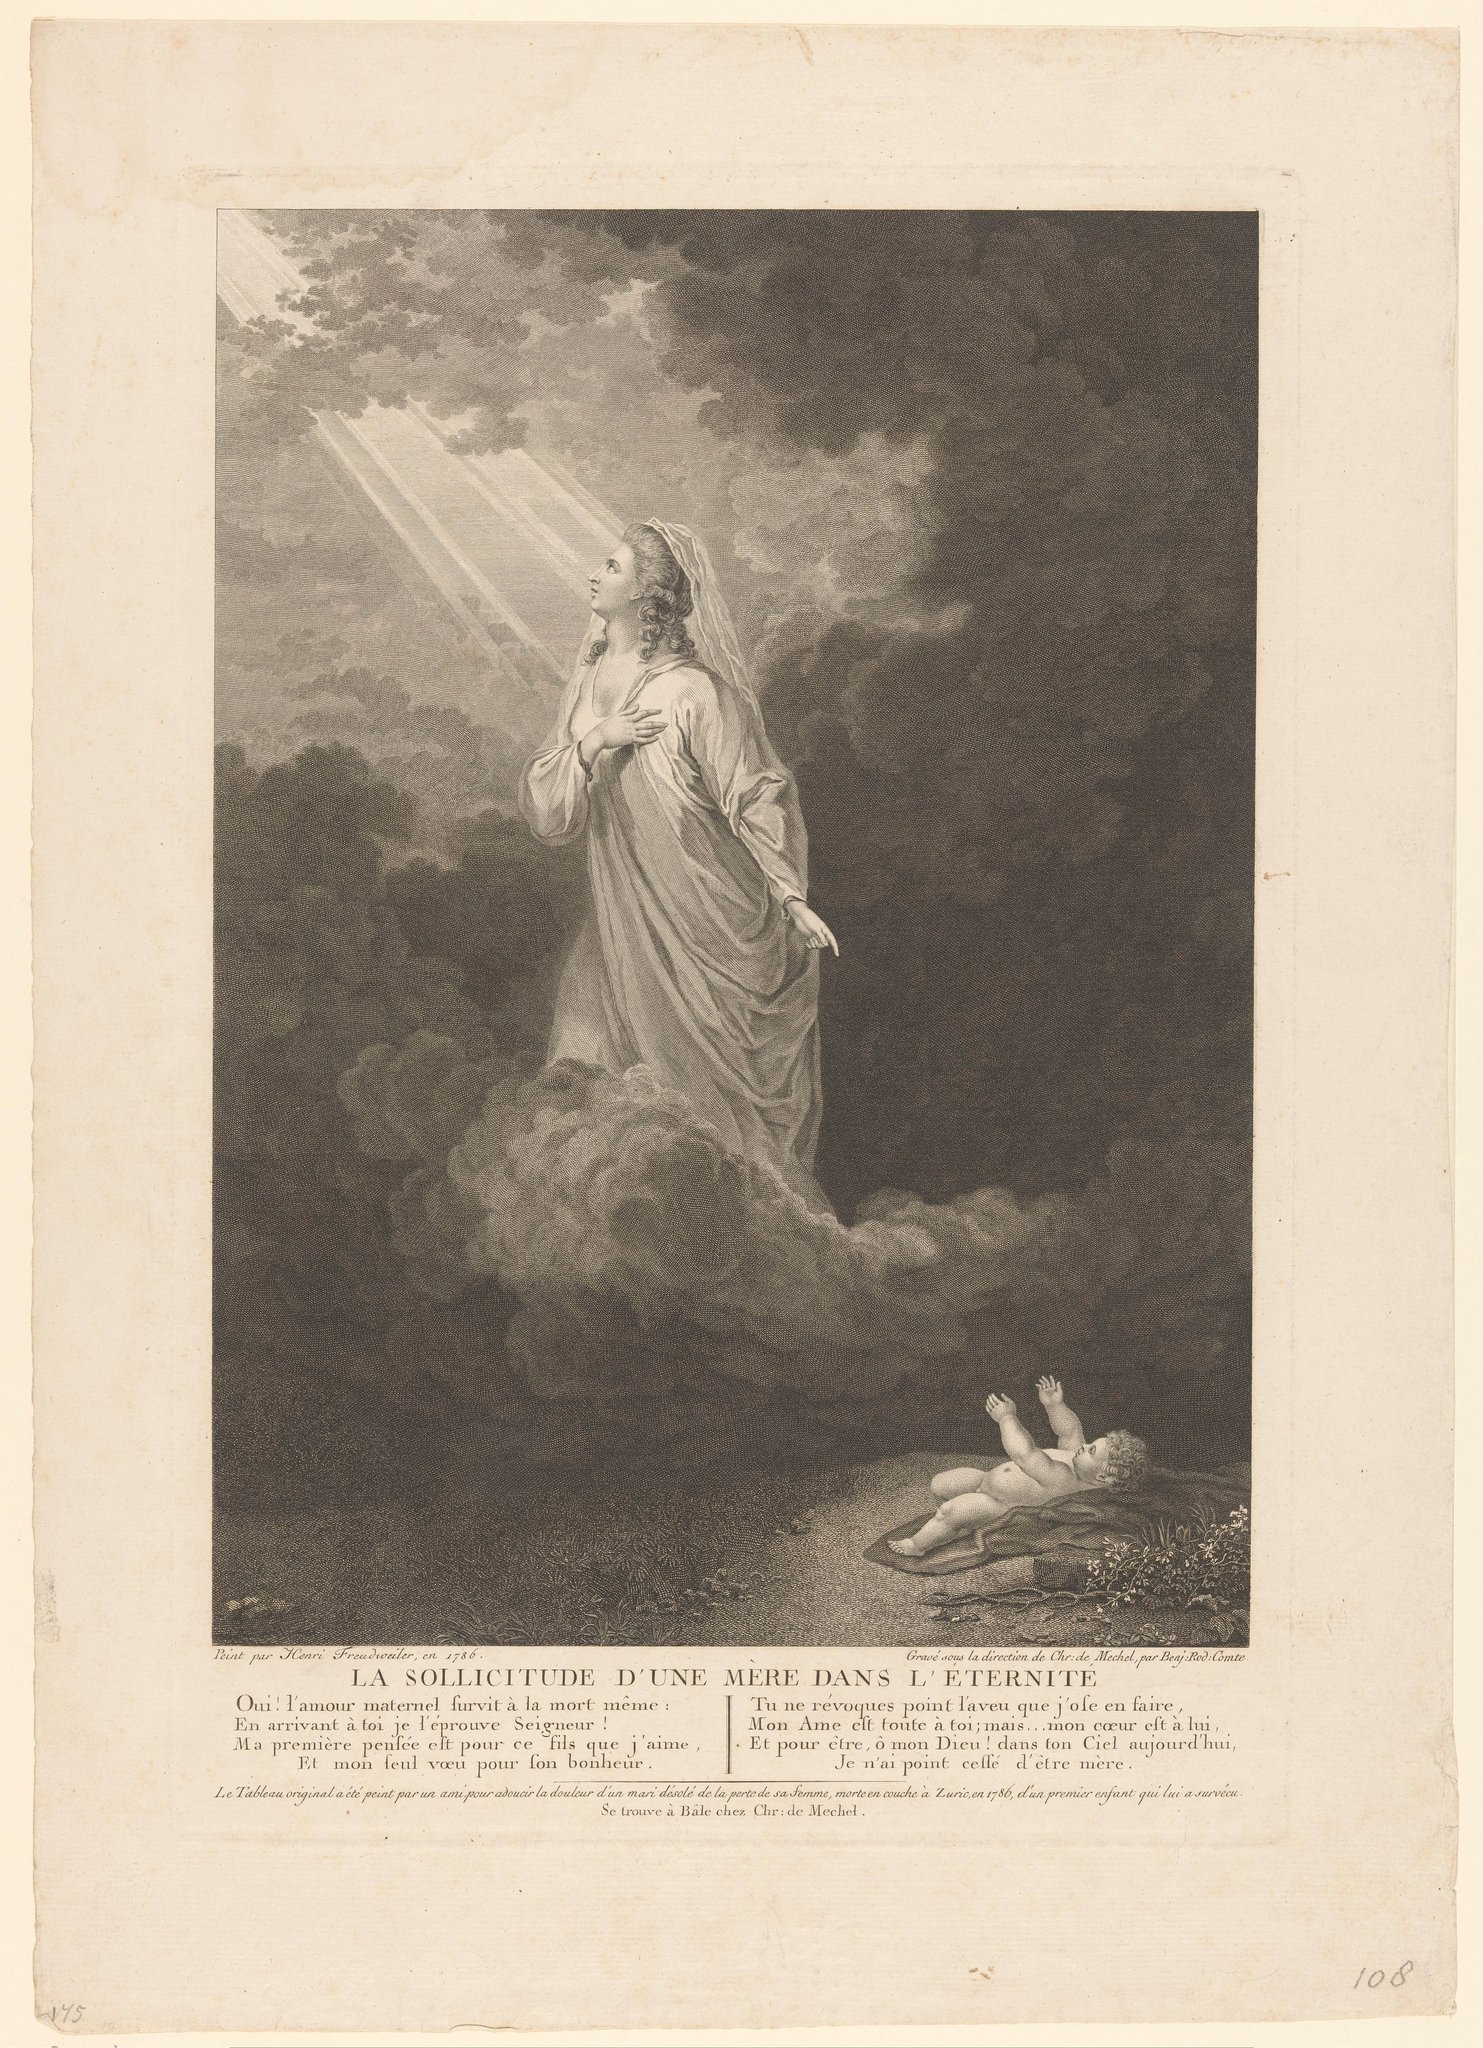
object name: print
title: La sollicitude d'une mère dans l'éternité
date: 1786-1843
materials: paper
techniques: engraving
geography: zurich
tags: mother and baby or young child, the new-born child, apotheosis (or ascension) of individuals, index finger forwards, pointing, indicating, anxiety, solicitude; 'sollecitudine' (ripa), looking upwards, death of human being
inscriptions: collector's mark: Lugt 2228